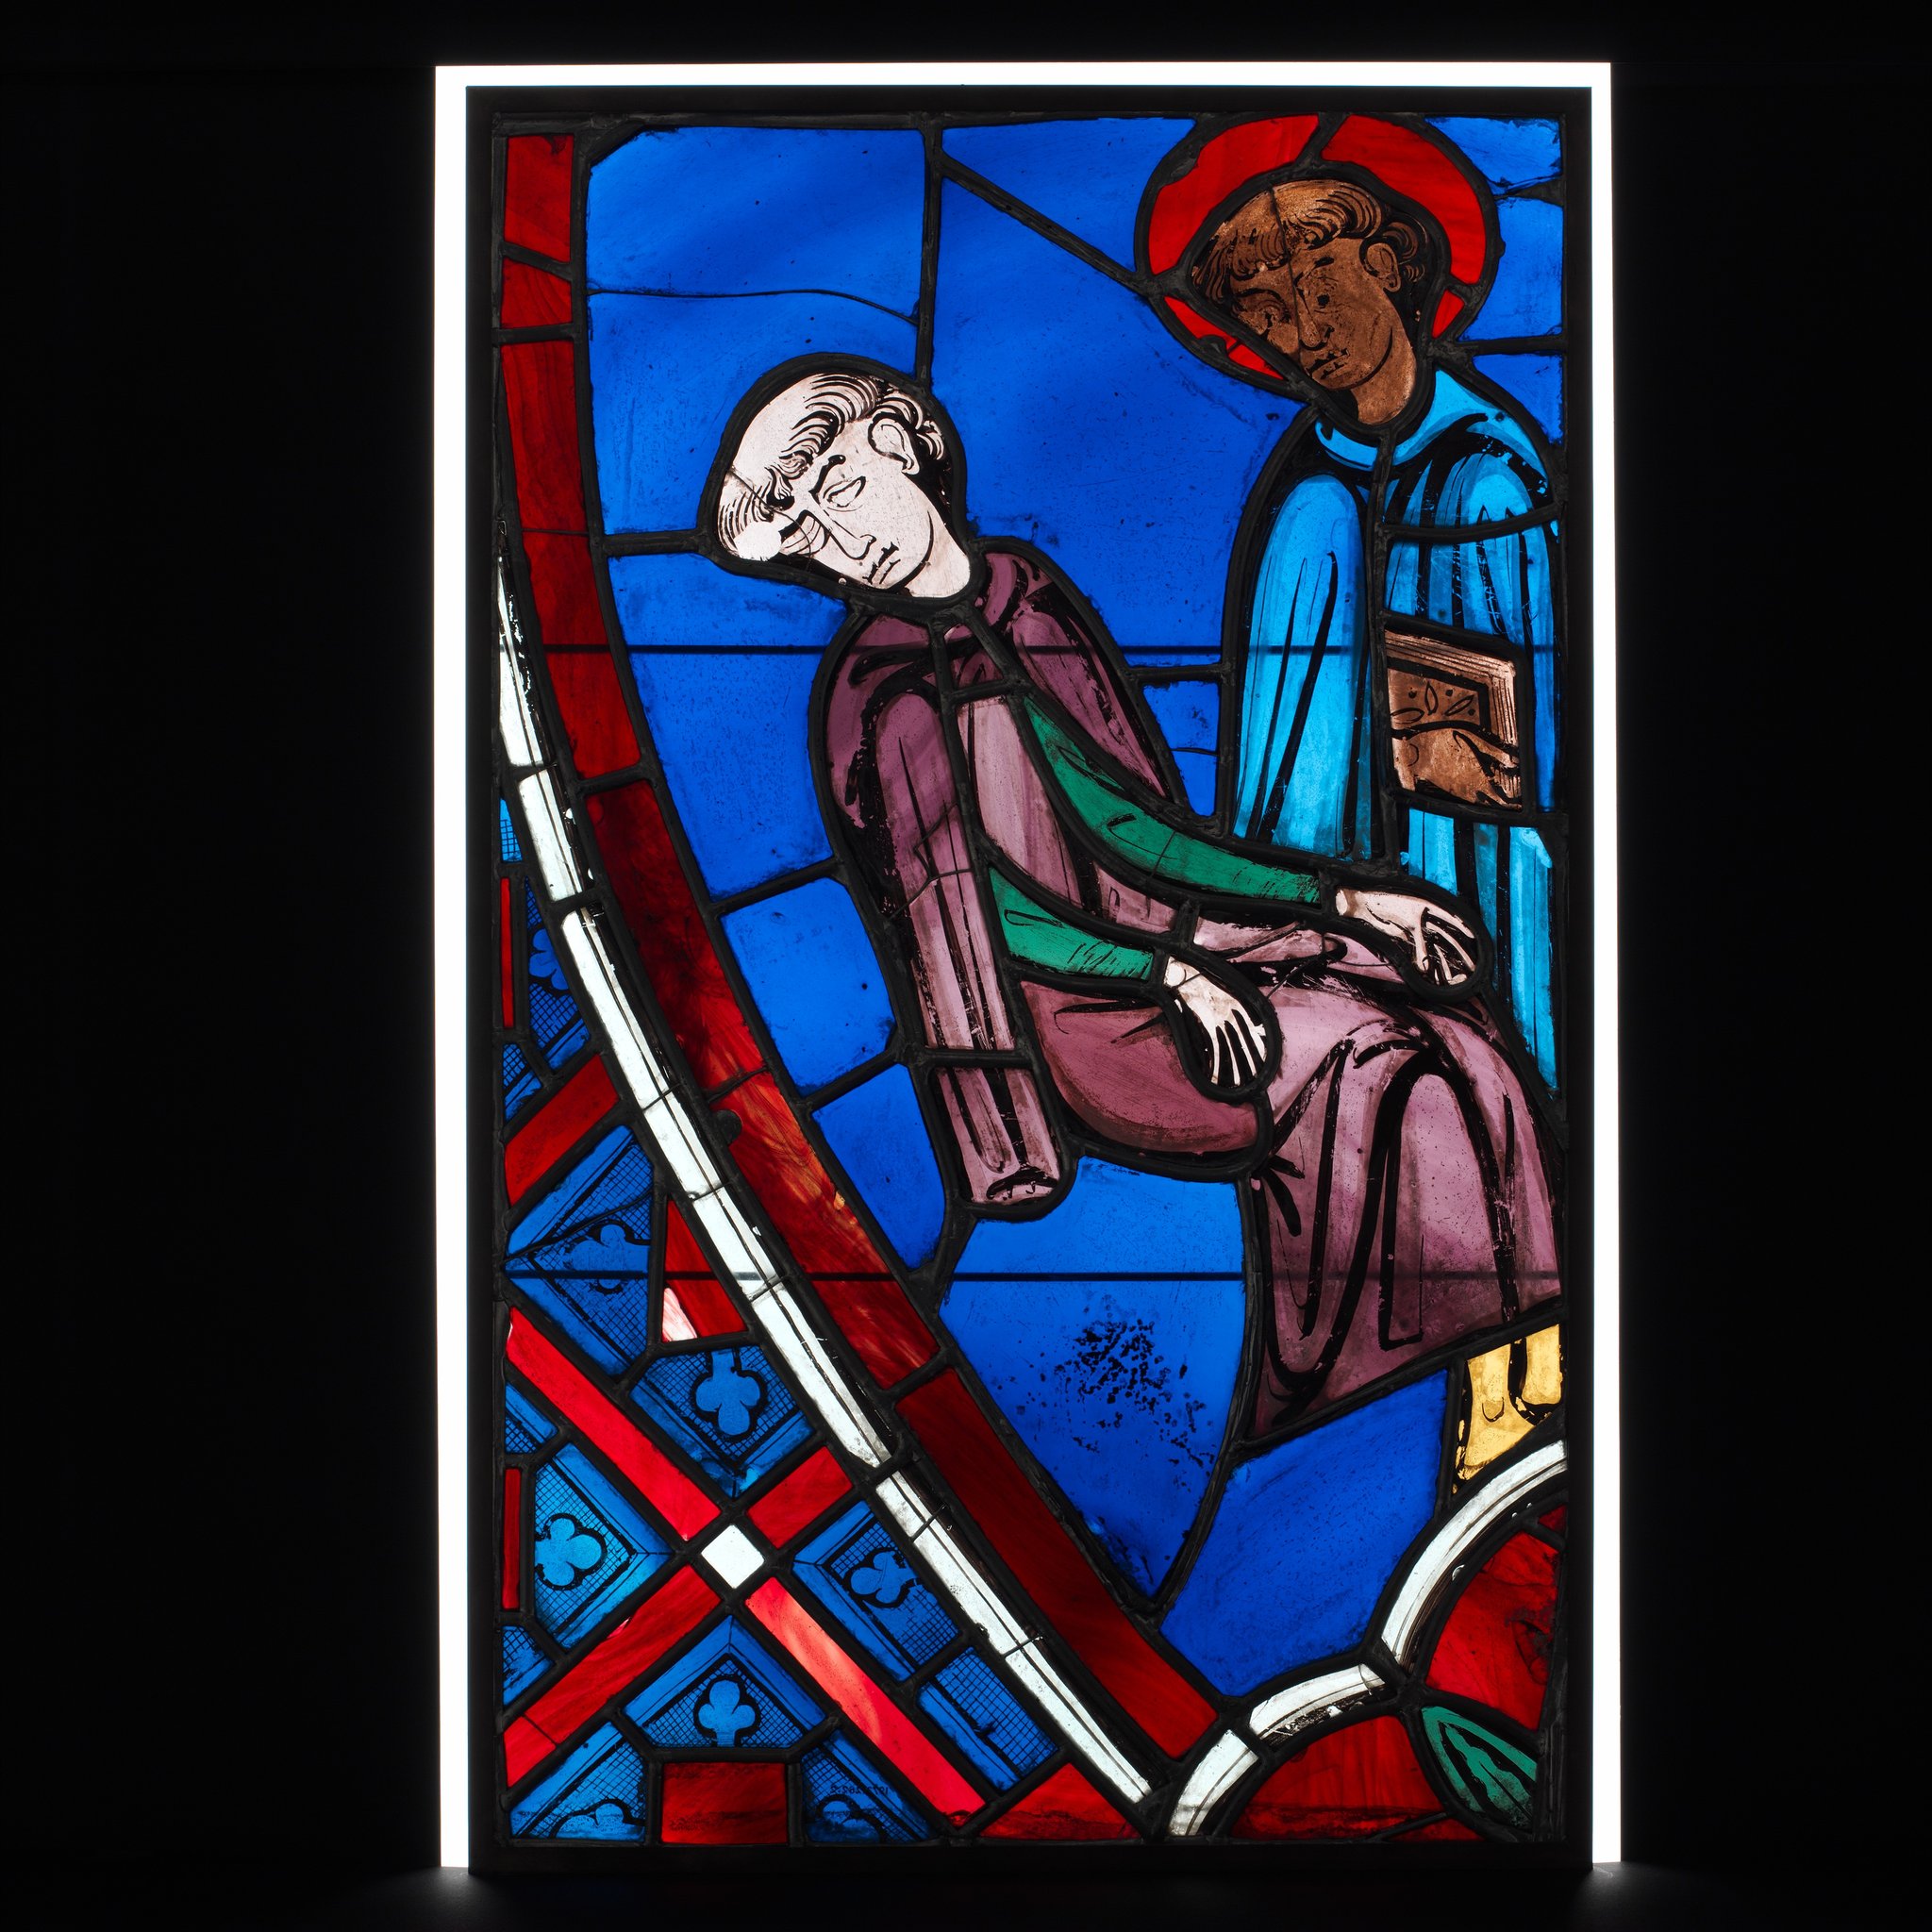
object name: panel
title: Vision of Saint Germain of Paris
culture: french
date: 1245-1247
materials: glass, metal, paint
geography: france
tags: men,saints